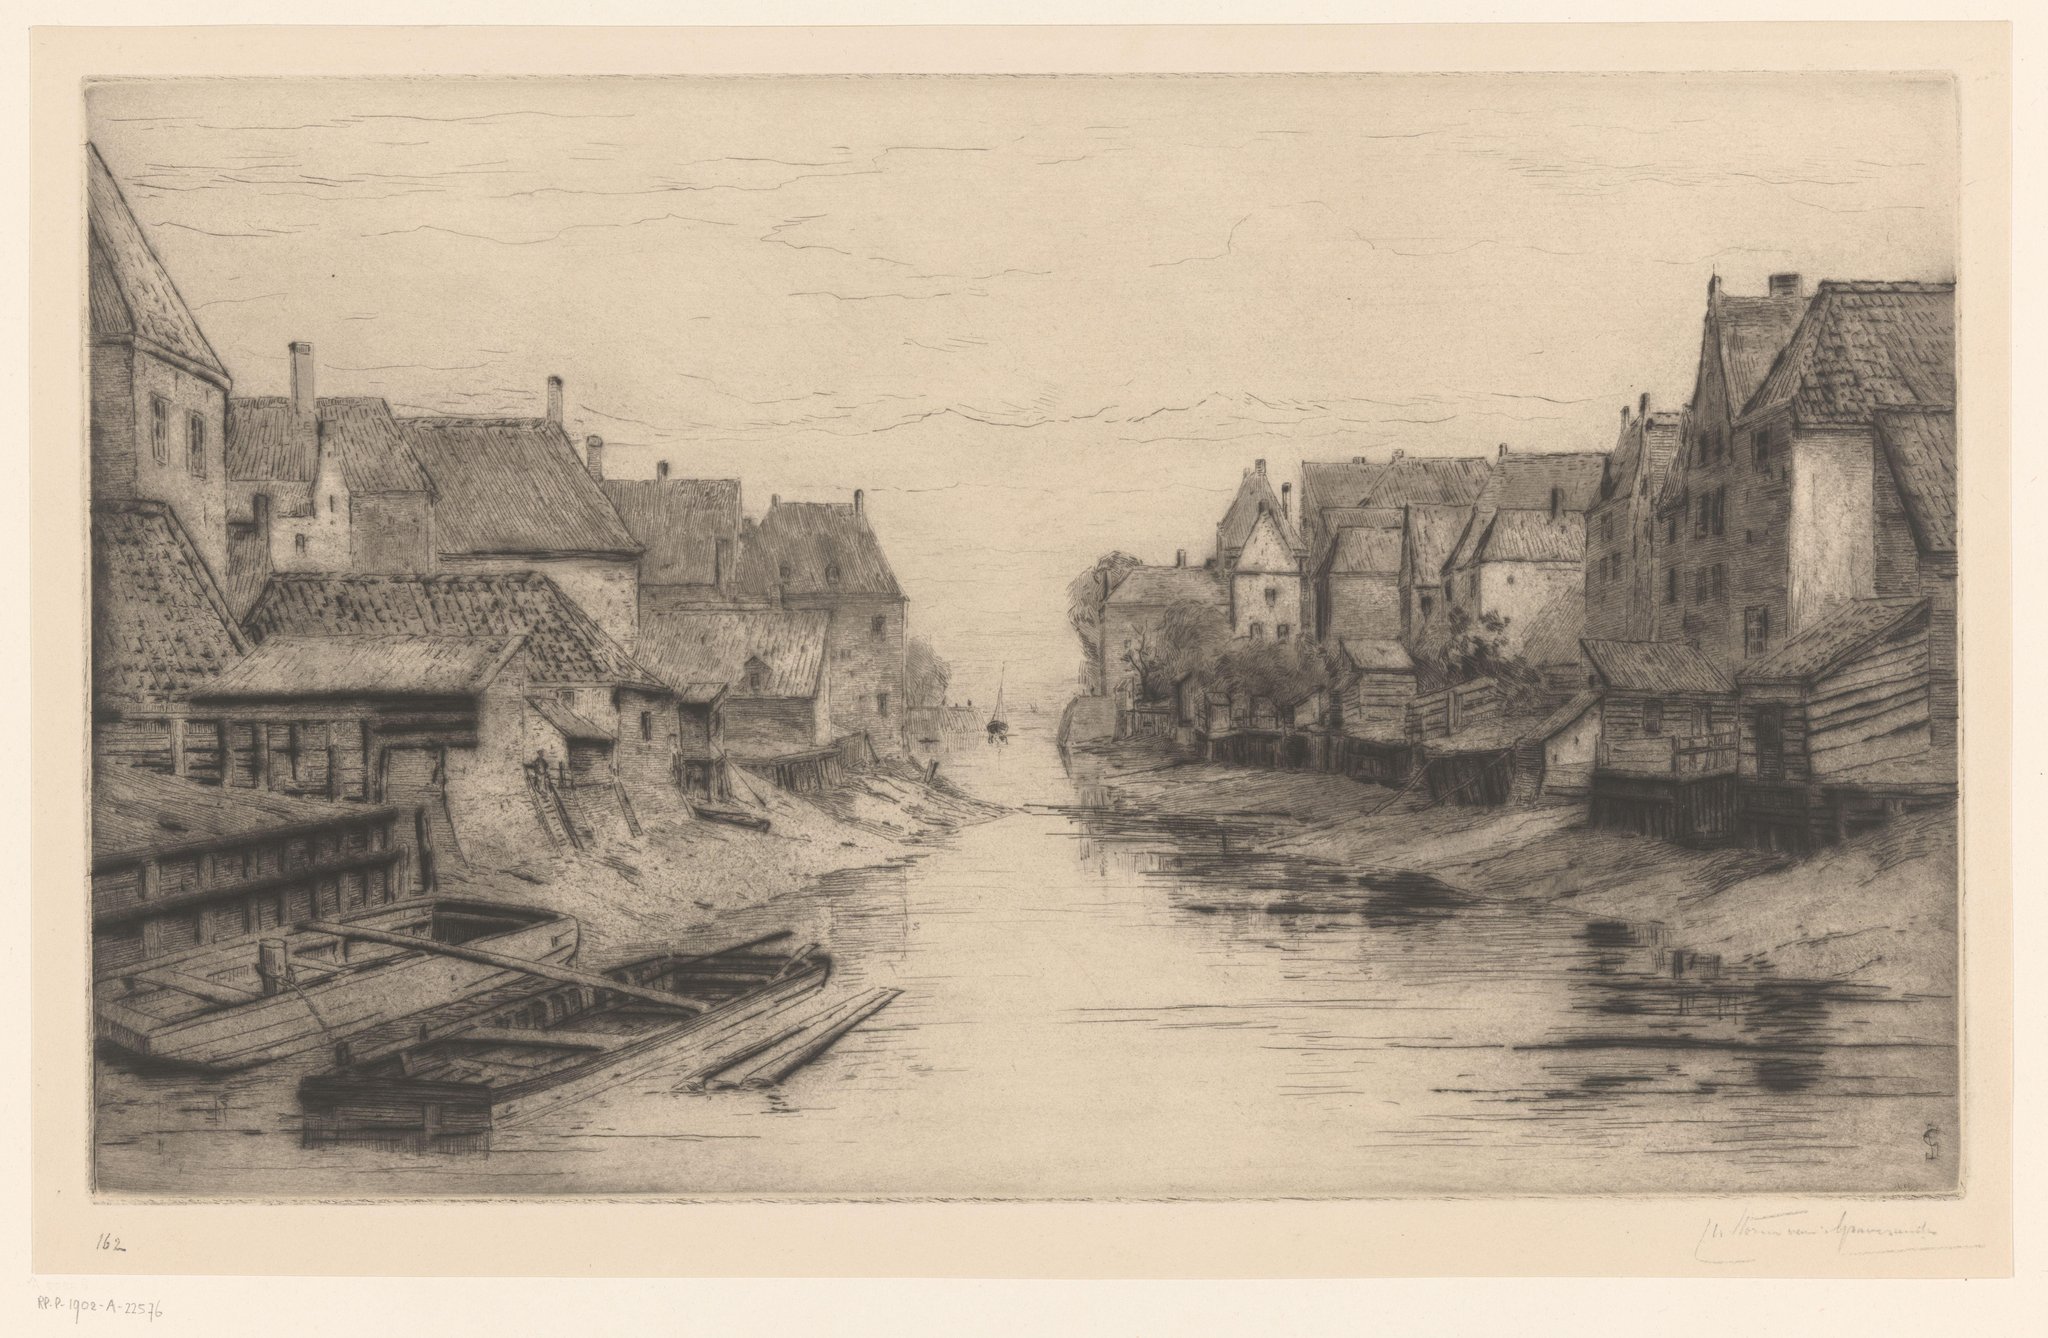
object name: print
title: Vieux port à Flessingue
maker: carel nicolaas storm van s-gravesande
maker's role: draughtsman, print maker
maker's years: 1841-1924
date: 1880-1884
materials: paper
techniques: drypoint, intaglio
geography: netherlands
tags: harbour, flushing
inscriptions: number: ‘162’, collector's mark: Lugt 2228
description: Mogelijk ook vermeld in: Storm van 's-Gravesande, Charles. Catalogue des eaux-fortes et lithographies. New York: s.n., 1903, of in een onbekende latere uitgave van het manuscript. Vermoedelijk vermeld als catalogusnummer 162.